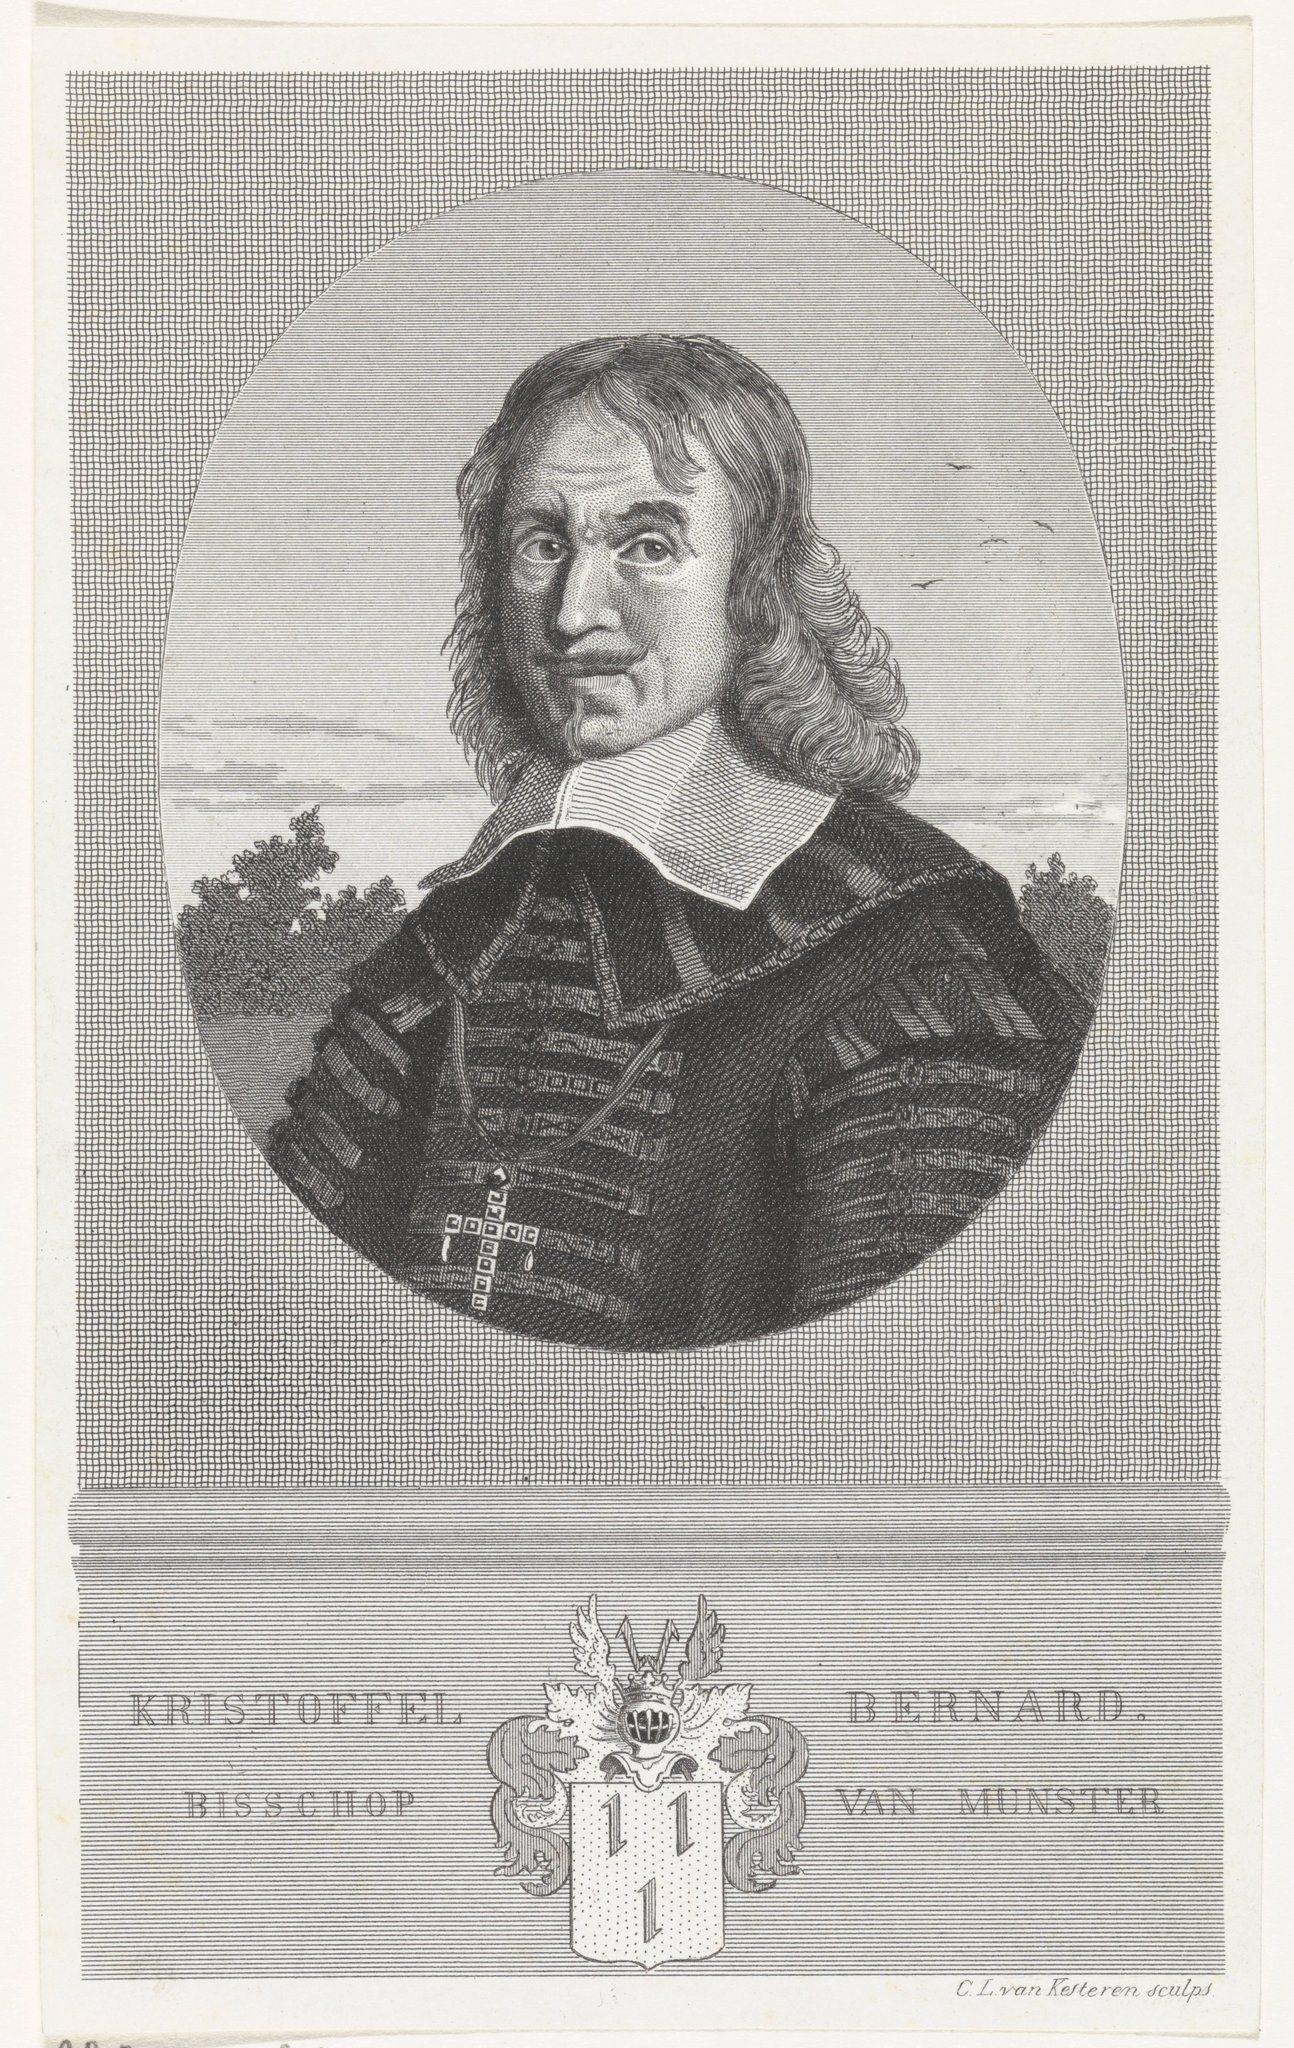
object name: print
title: Kristoffel Bernard bisschop van Munster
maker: christiaan lodewijk van kesteren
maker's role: print maker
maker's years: 1832-1897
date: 1842-1897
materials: paper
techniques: engraving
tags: christoph bernhard von galen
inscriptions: collector's mark: Lugt 2228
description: Portretbuste naar links in ovaal van Christoph Bernhard von Galen, bisschop van Münster. Van Galen draagt een ketting met een kruis en in de marge staat zijn wapen.